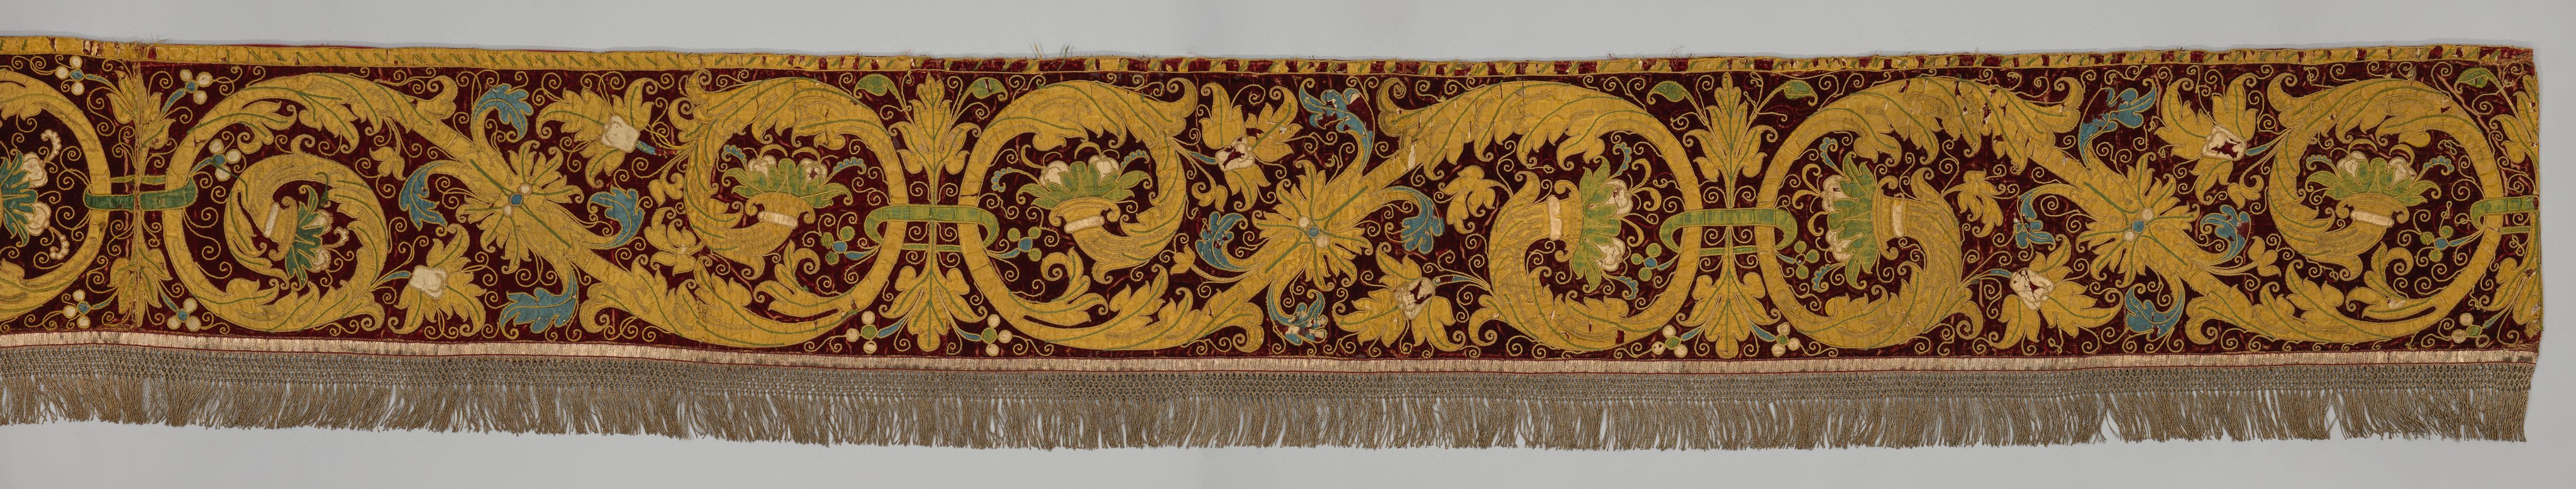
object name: embroidery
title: Lambrekijn of strook van applicatie borduurwerk; satijn en koordzijde op fluweel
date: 1550-1600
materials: textile, silk, velvet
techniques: embroidered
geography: italy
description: Lambrekijn of strook van applicatie-borduurwerk; satijn en koordzijde op fluweel. Op een wijnrood fond heeft het patroon gele, liggende S-ranken binnen een omlijsting van geel. Zijden damast is gebruikt voor de knooppunten, voor het hart van een palmetbloem, voor acanthusbladeren en voor de voluut beeindiging. De contouren en enkele hechtranken zijn van koordzijde in geel en groen. Bij de strook of lambrekijn hoort een tweede strook of lambrekijn.